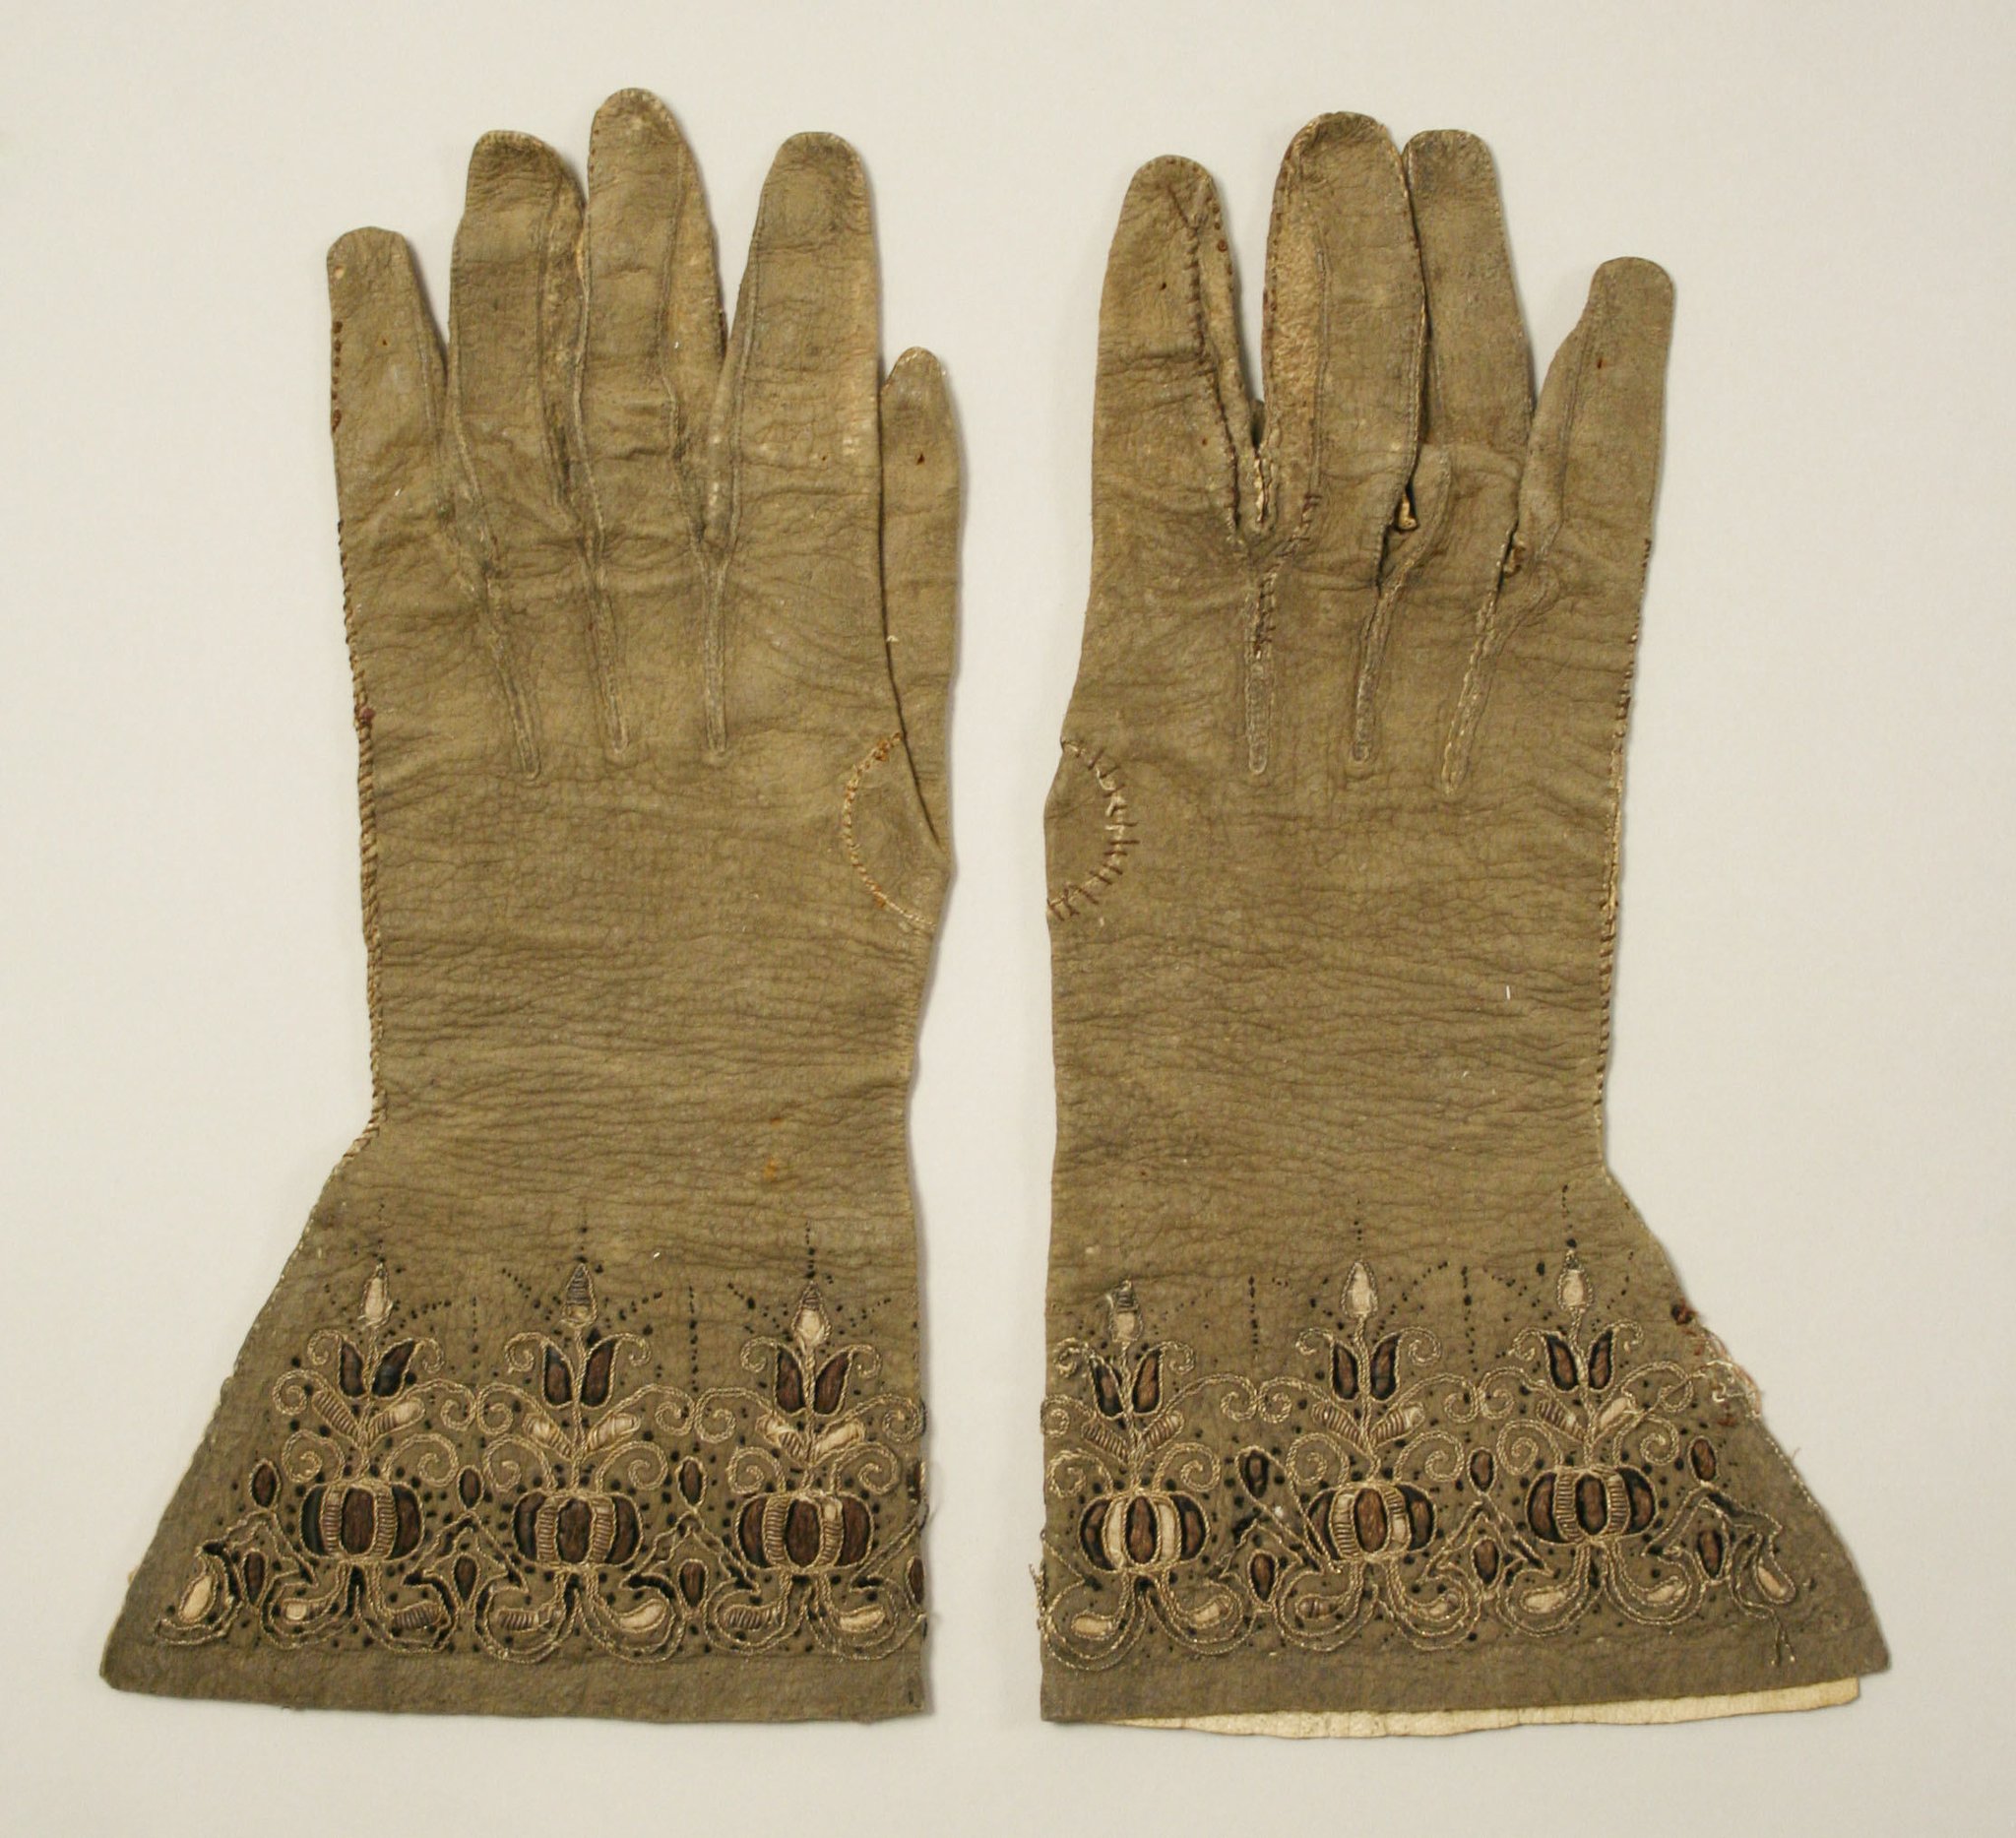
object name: glove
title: Gloves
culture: british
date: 1501-1600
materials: leather